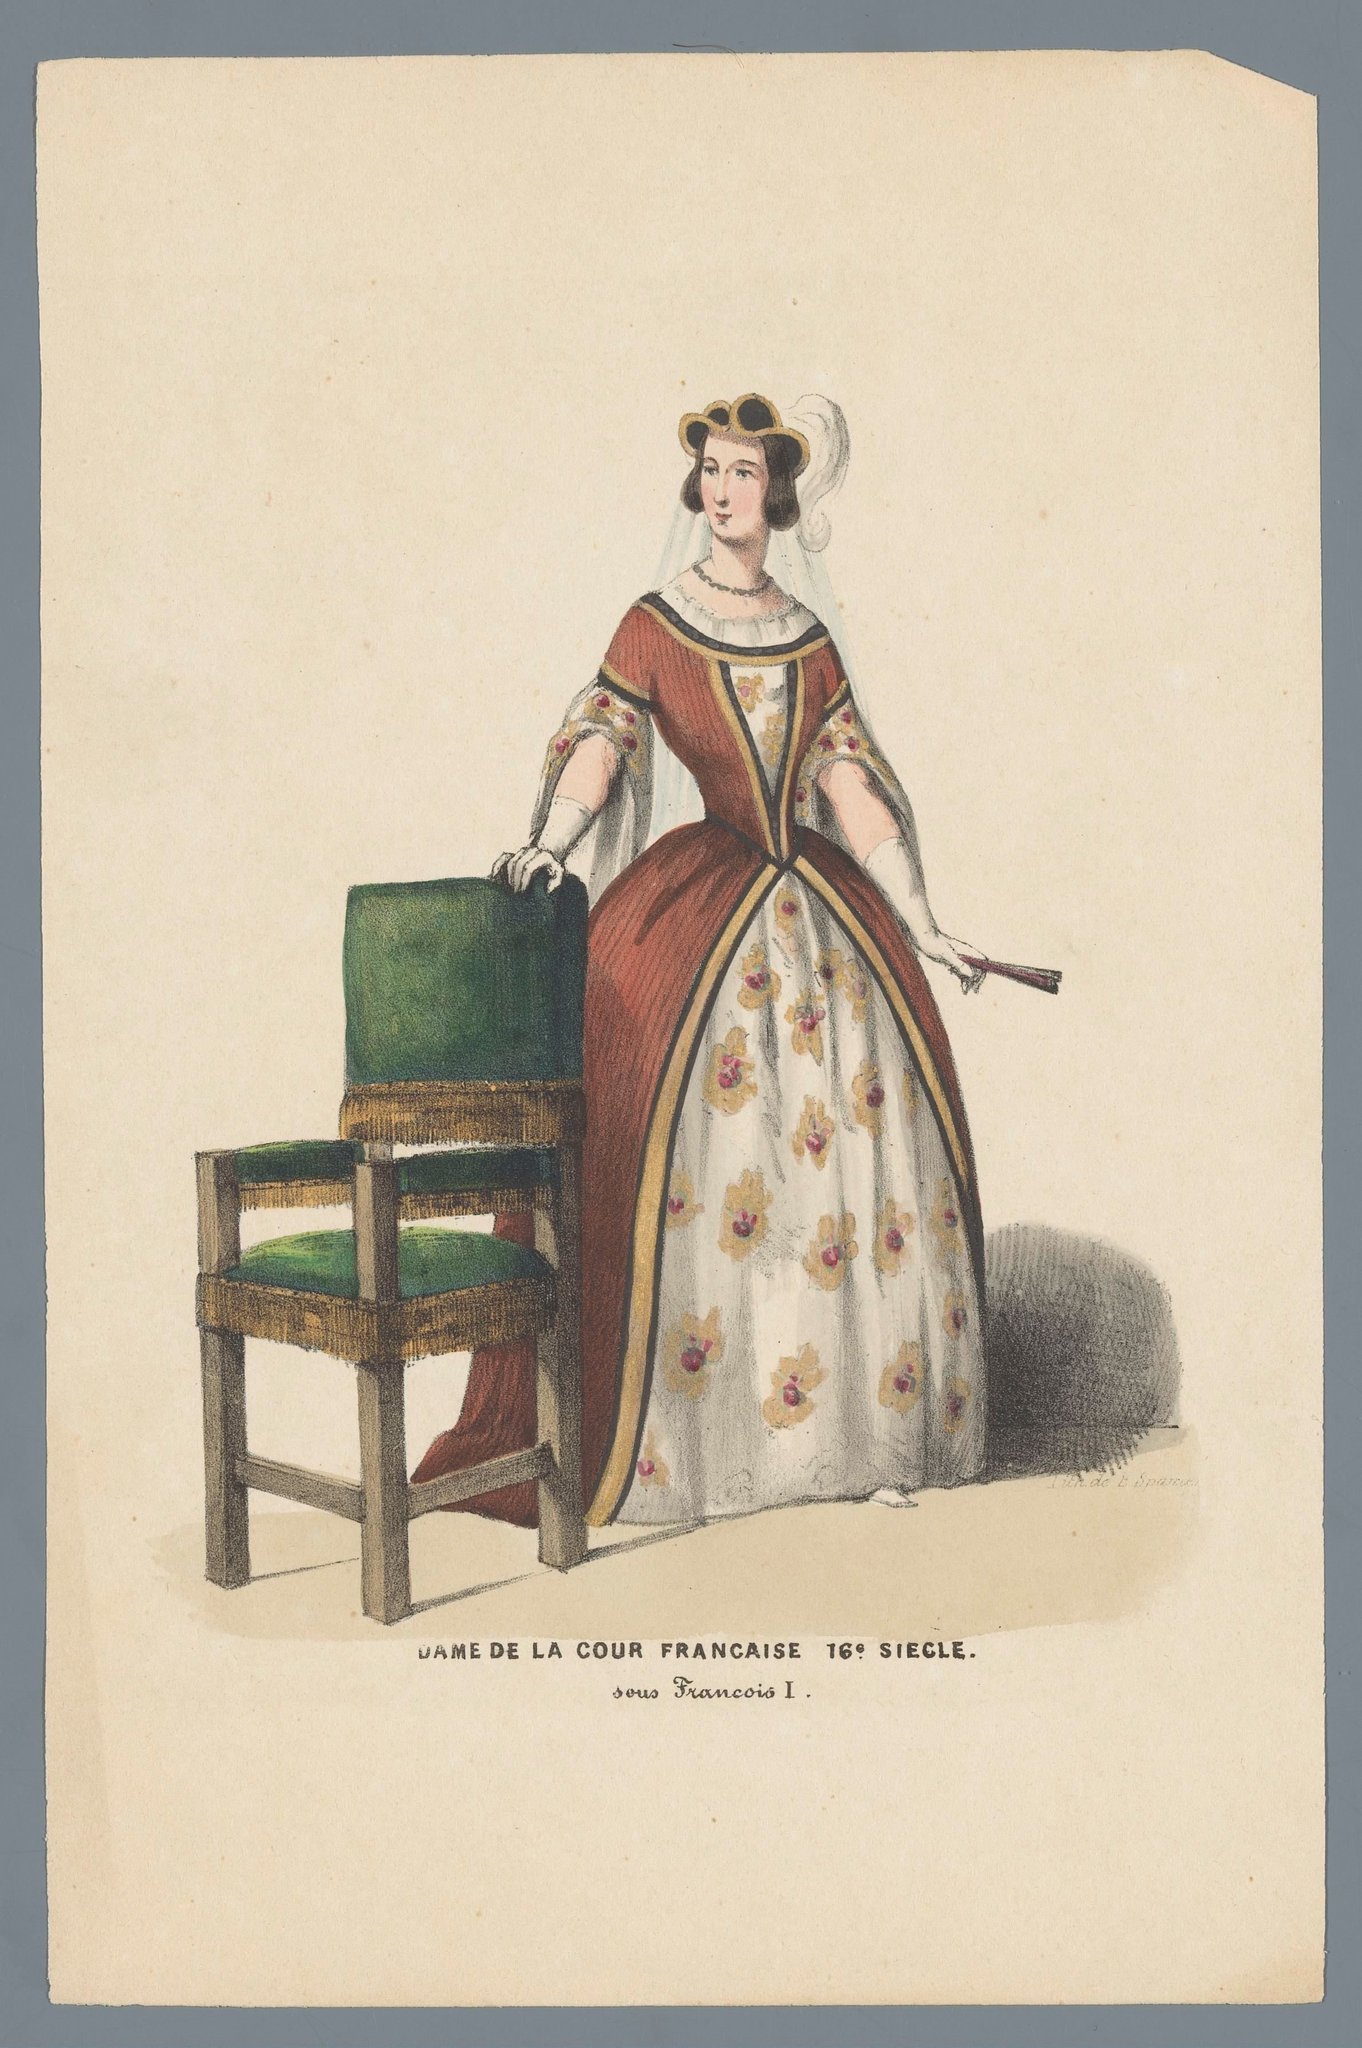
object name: costume print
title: Dame de la cour Francaise XVI Siècle. sous Francois I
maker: elias spanier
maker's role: print maker, printer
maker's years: 1821-1863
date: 1840-1850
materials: paper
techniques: hand coloring, lithograph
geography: the hague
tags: historical costume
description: Vrouw in historisch kostuum van een hofdame aan het hof van Frans I, 16e eeuw. Voorstelling toegevoegd aan het plaatwerk over het gekostumeerd bal gehouden op het paleis van de prins van Oranje (de latere koning Willem III) in Den Haag op 26 februari 1845.